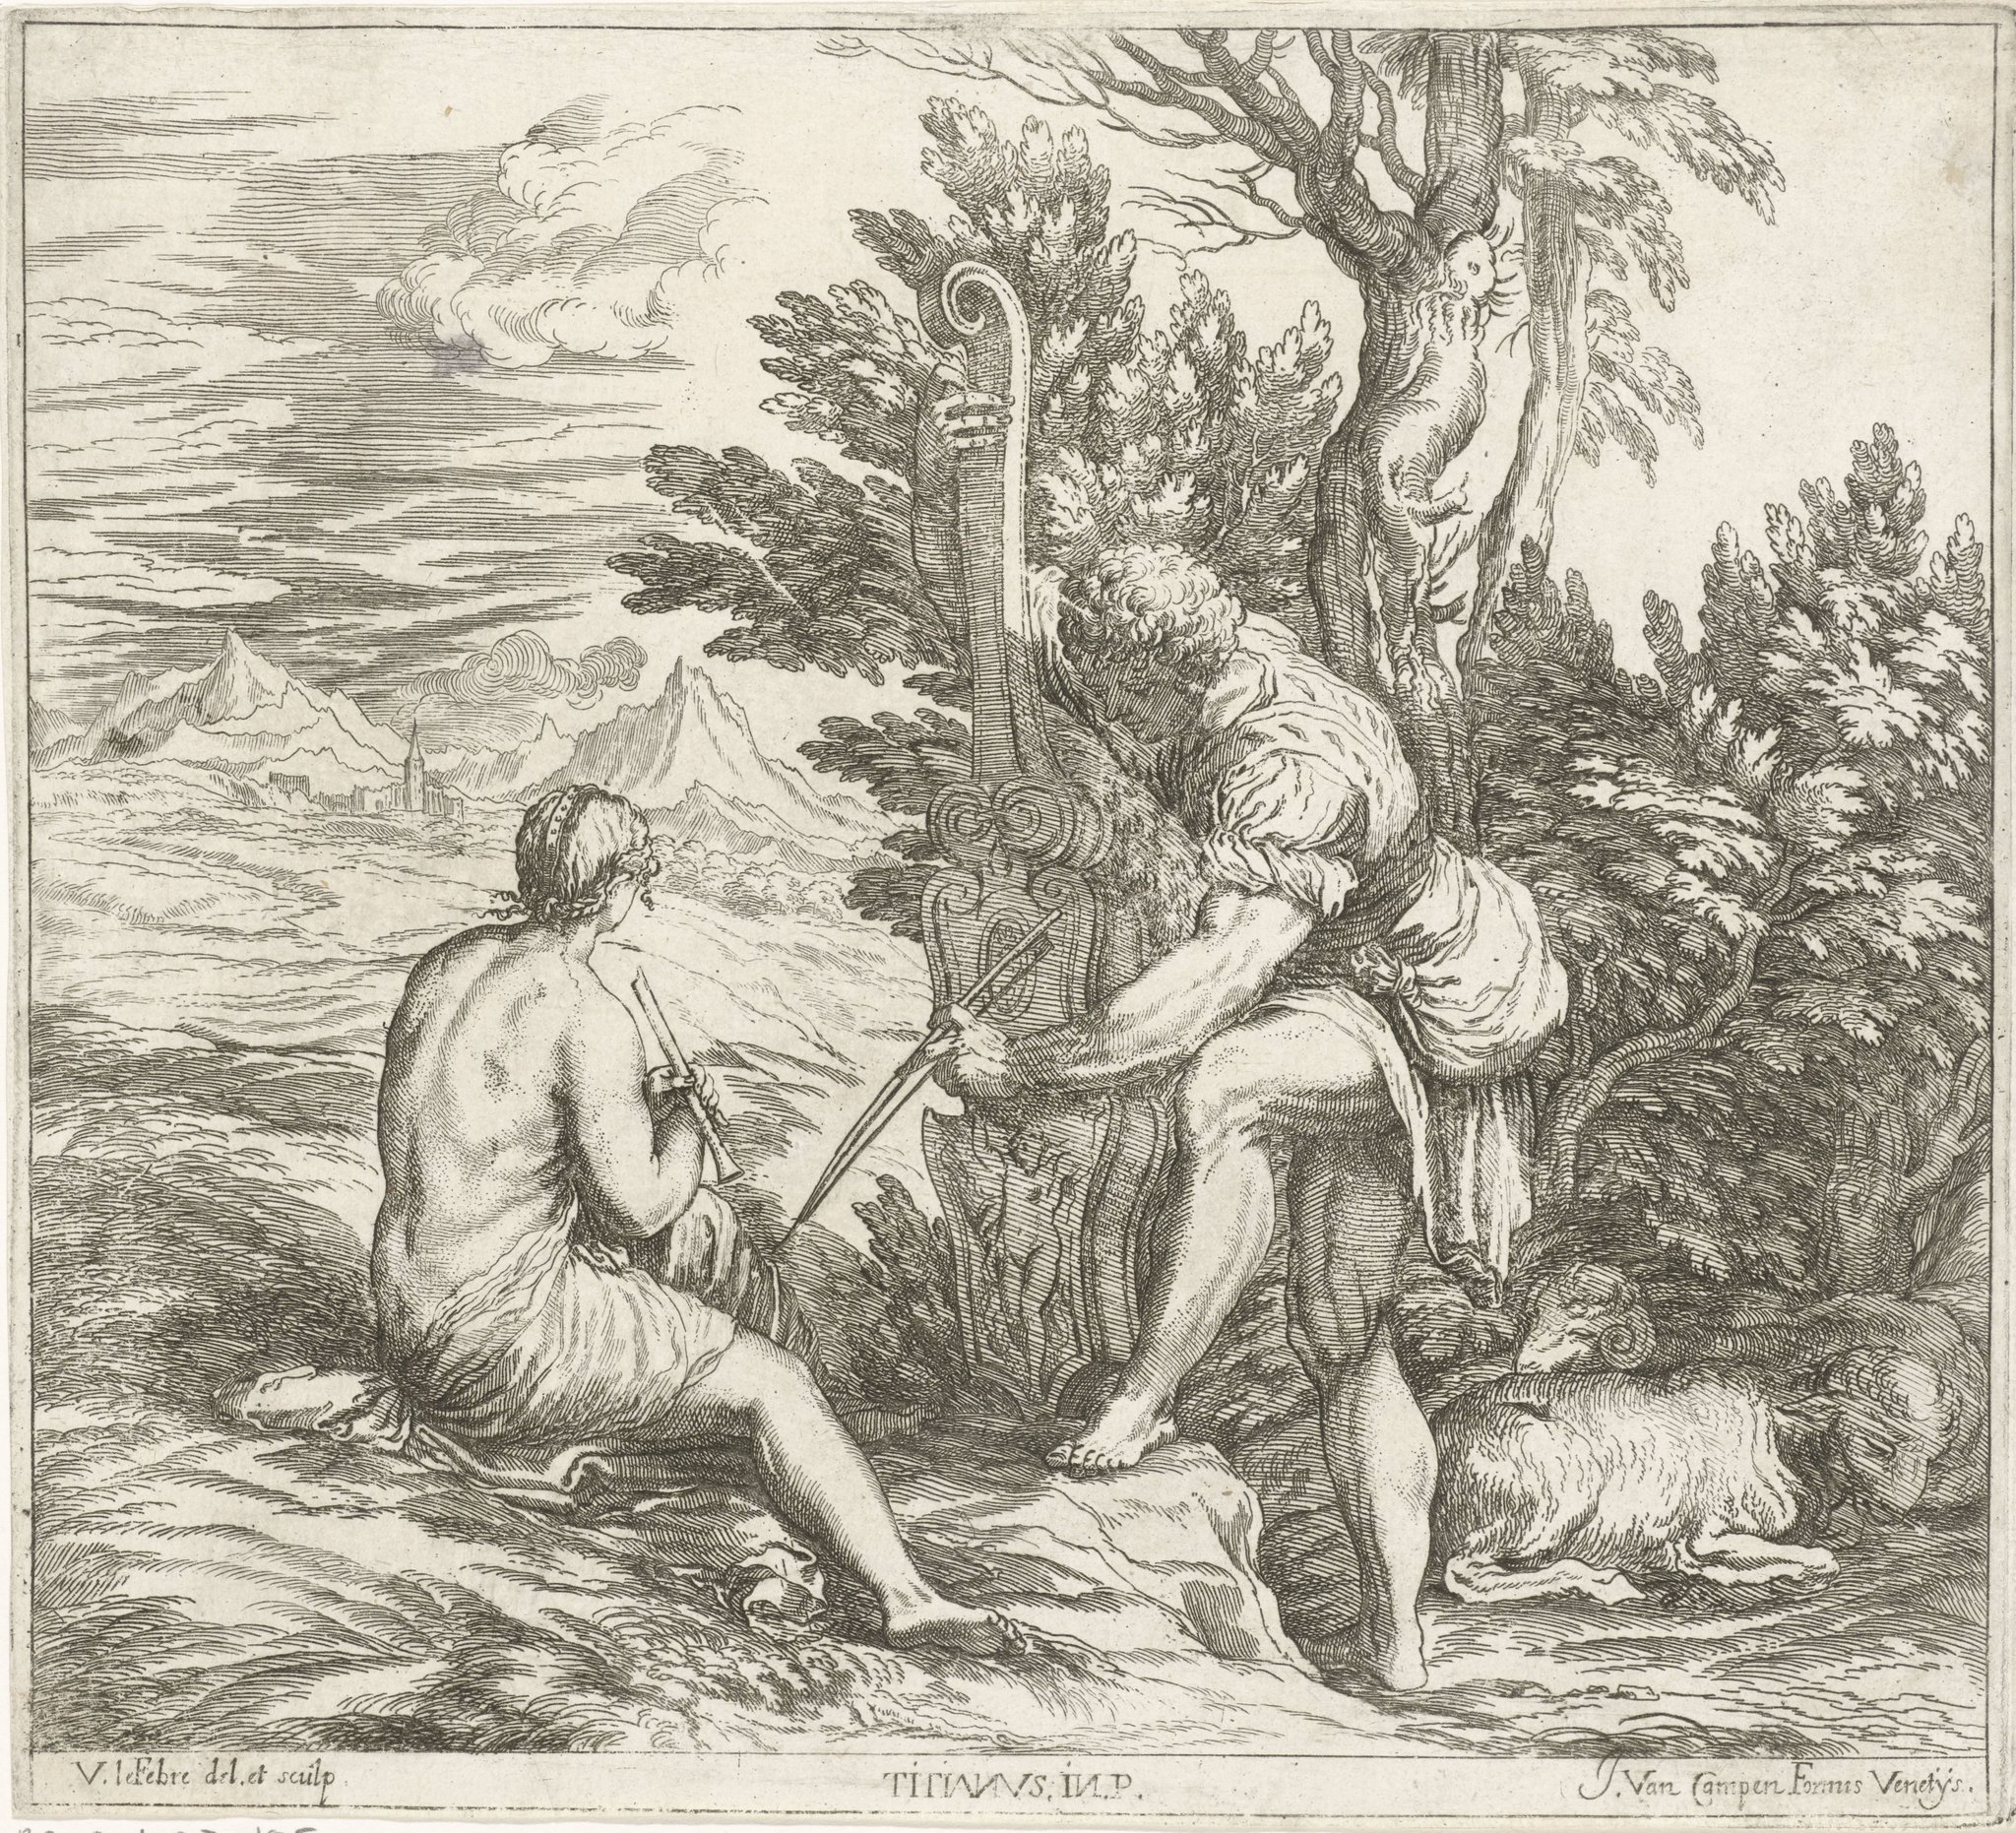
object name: print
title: Musicerend gezelschap in de buitenlucht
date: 1682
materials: paper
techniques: etching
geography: venice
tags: sheep, small group of musicians, chamber orchestra, jazz band - cc - 'concert champêtre', mountains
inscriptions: collector's mark: Lugt 2228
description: In een landschap bespeelt een jongeman staande een basgamba. Een vrouw, op de rug gezien, zit met een fluit in haar hand naast hem. De prent maakt deel uit van een 53-delige serie prenten naar schilderijen van Titiaan en Veronese.